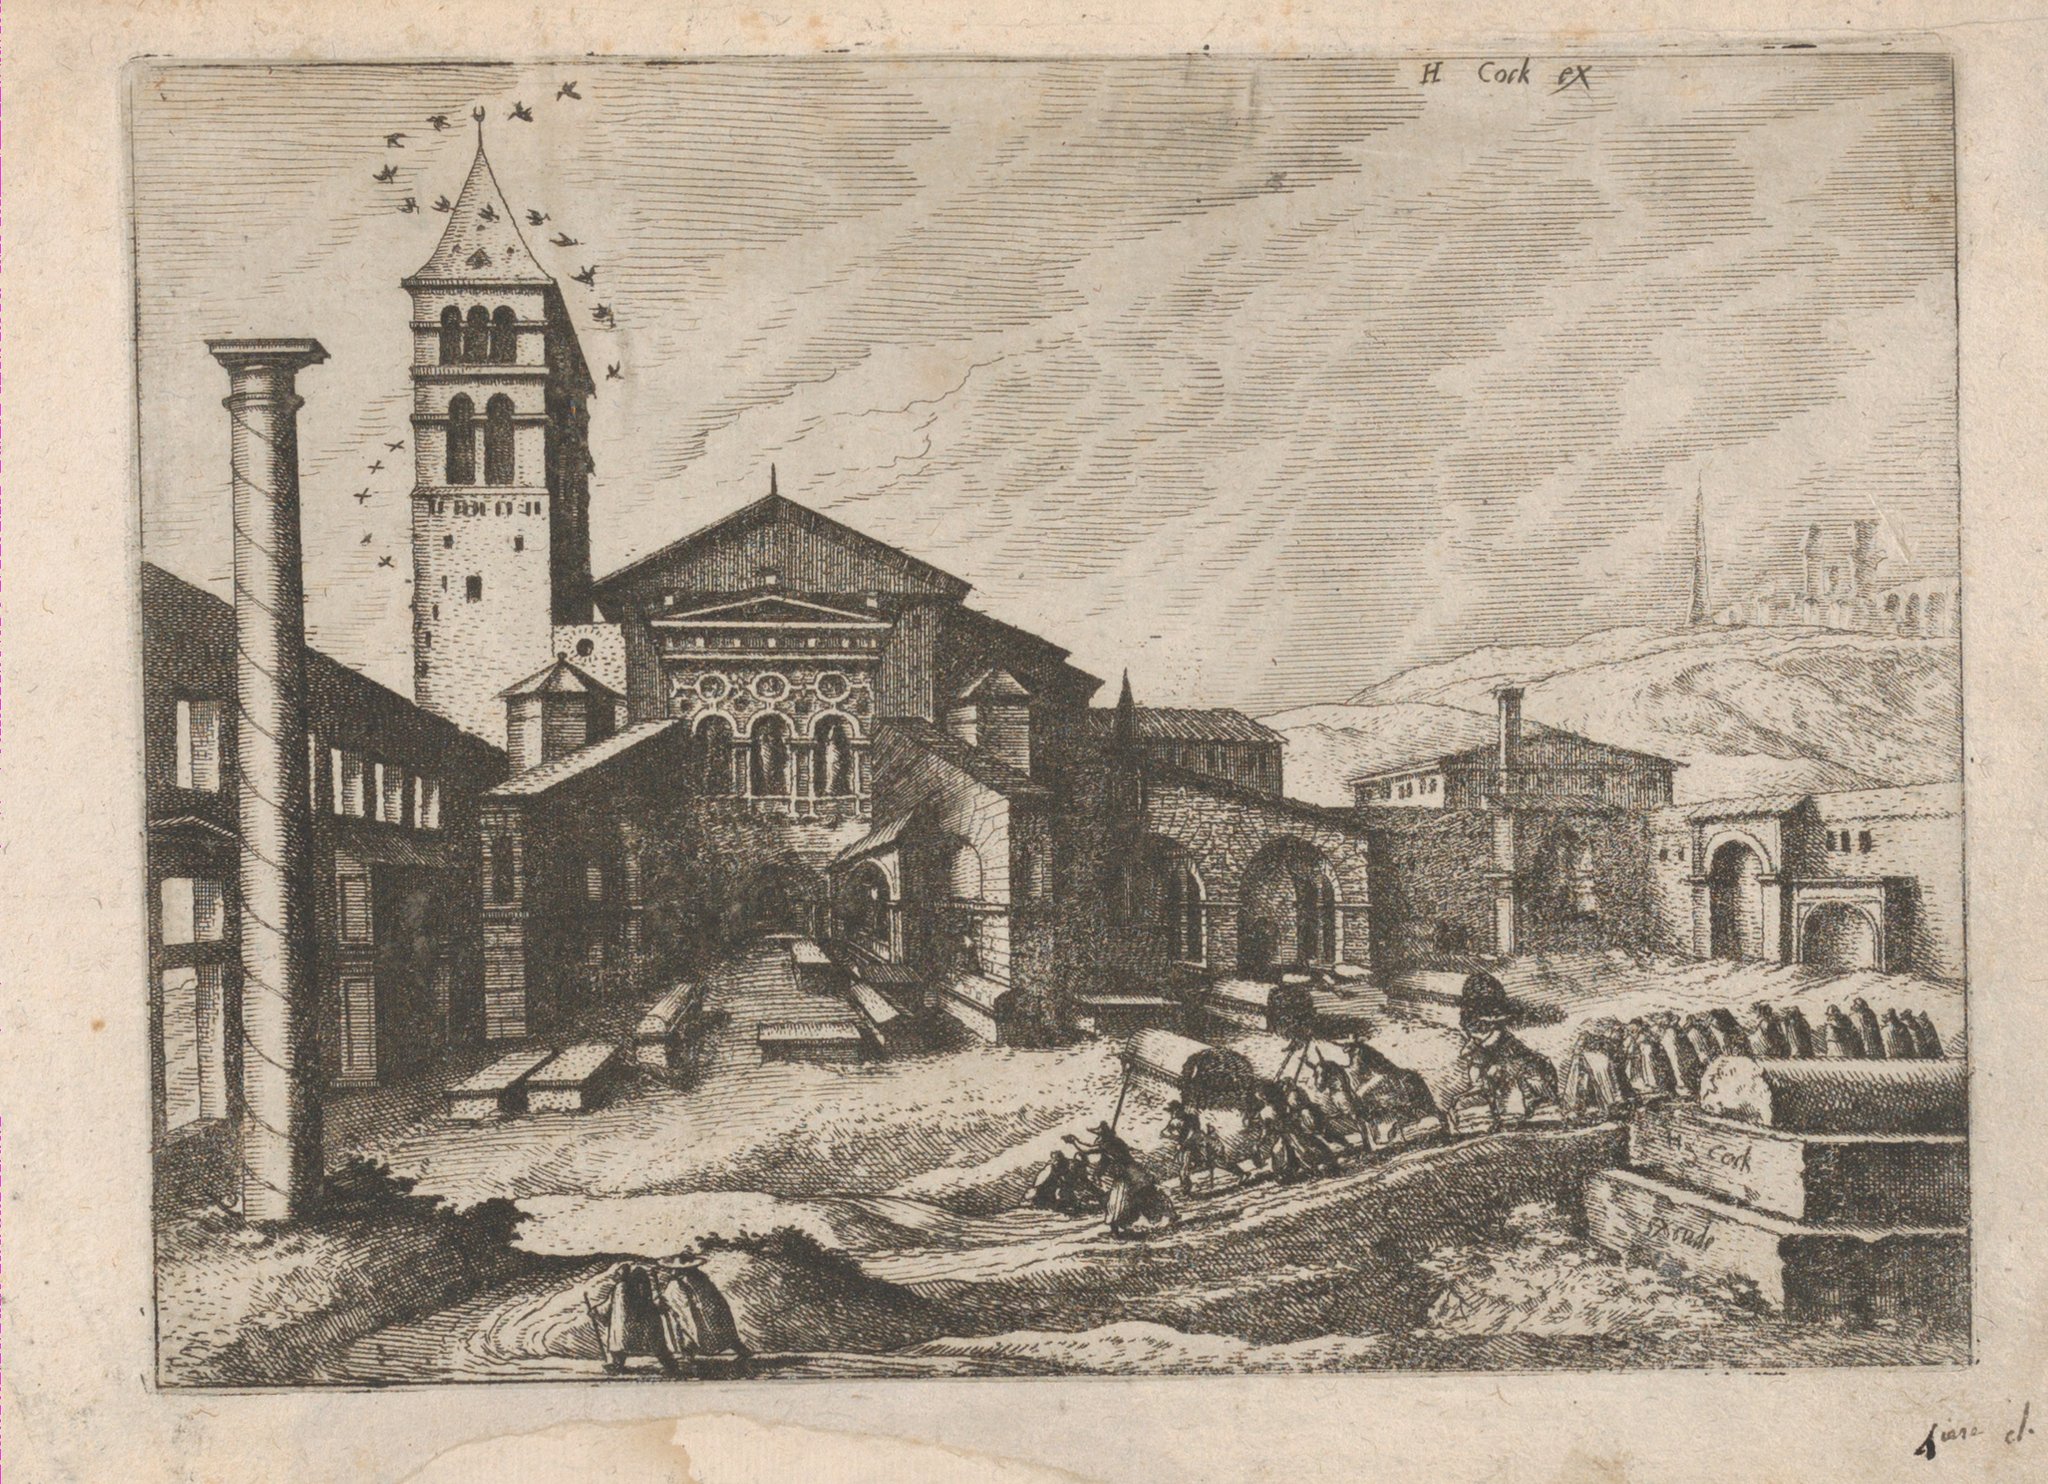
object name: print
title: City with a Column and a Church, from "Roman Ruins and Buildings"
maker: johannes van doetecum i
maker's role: artist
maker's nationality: netherlandish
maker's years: 1528-1605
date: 1562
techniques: engraving, etching